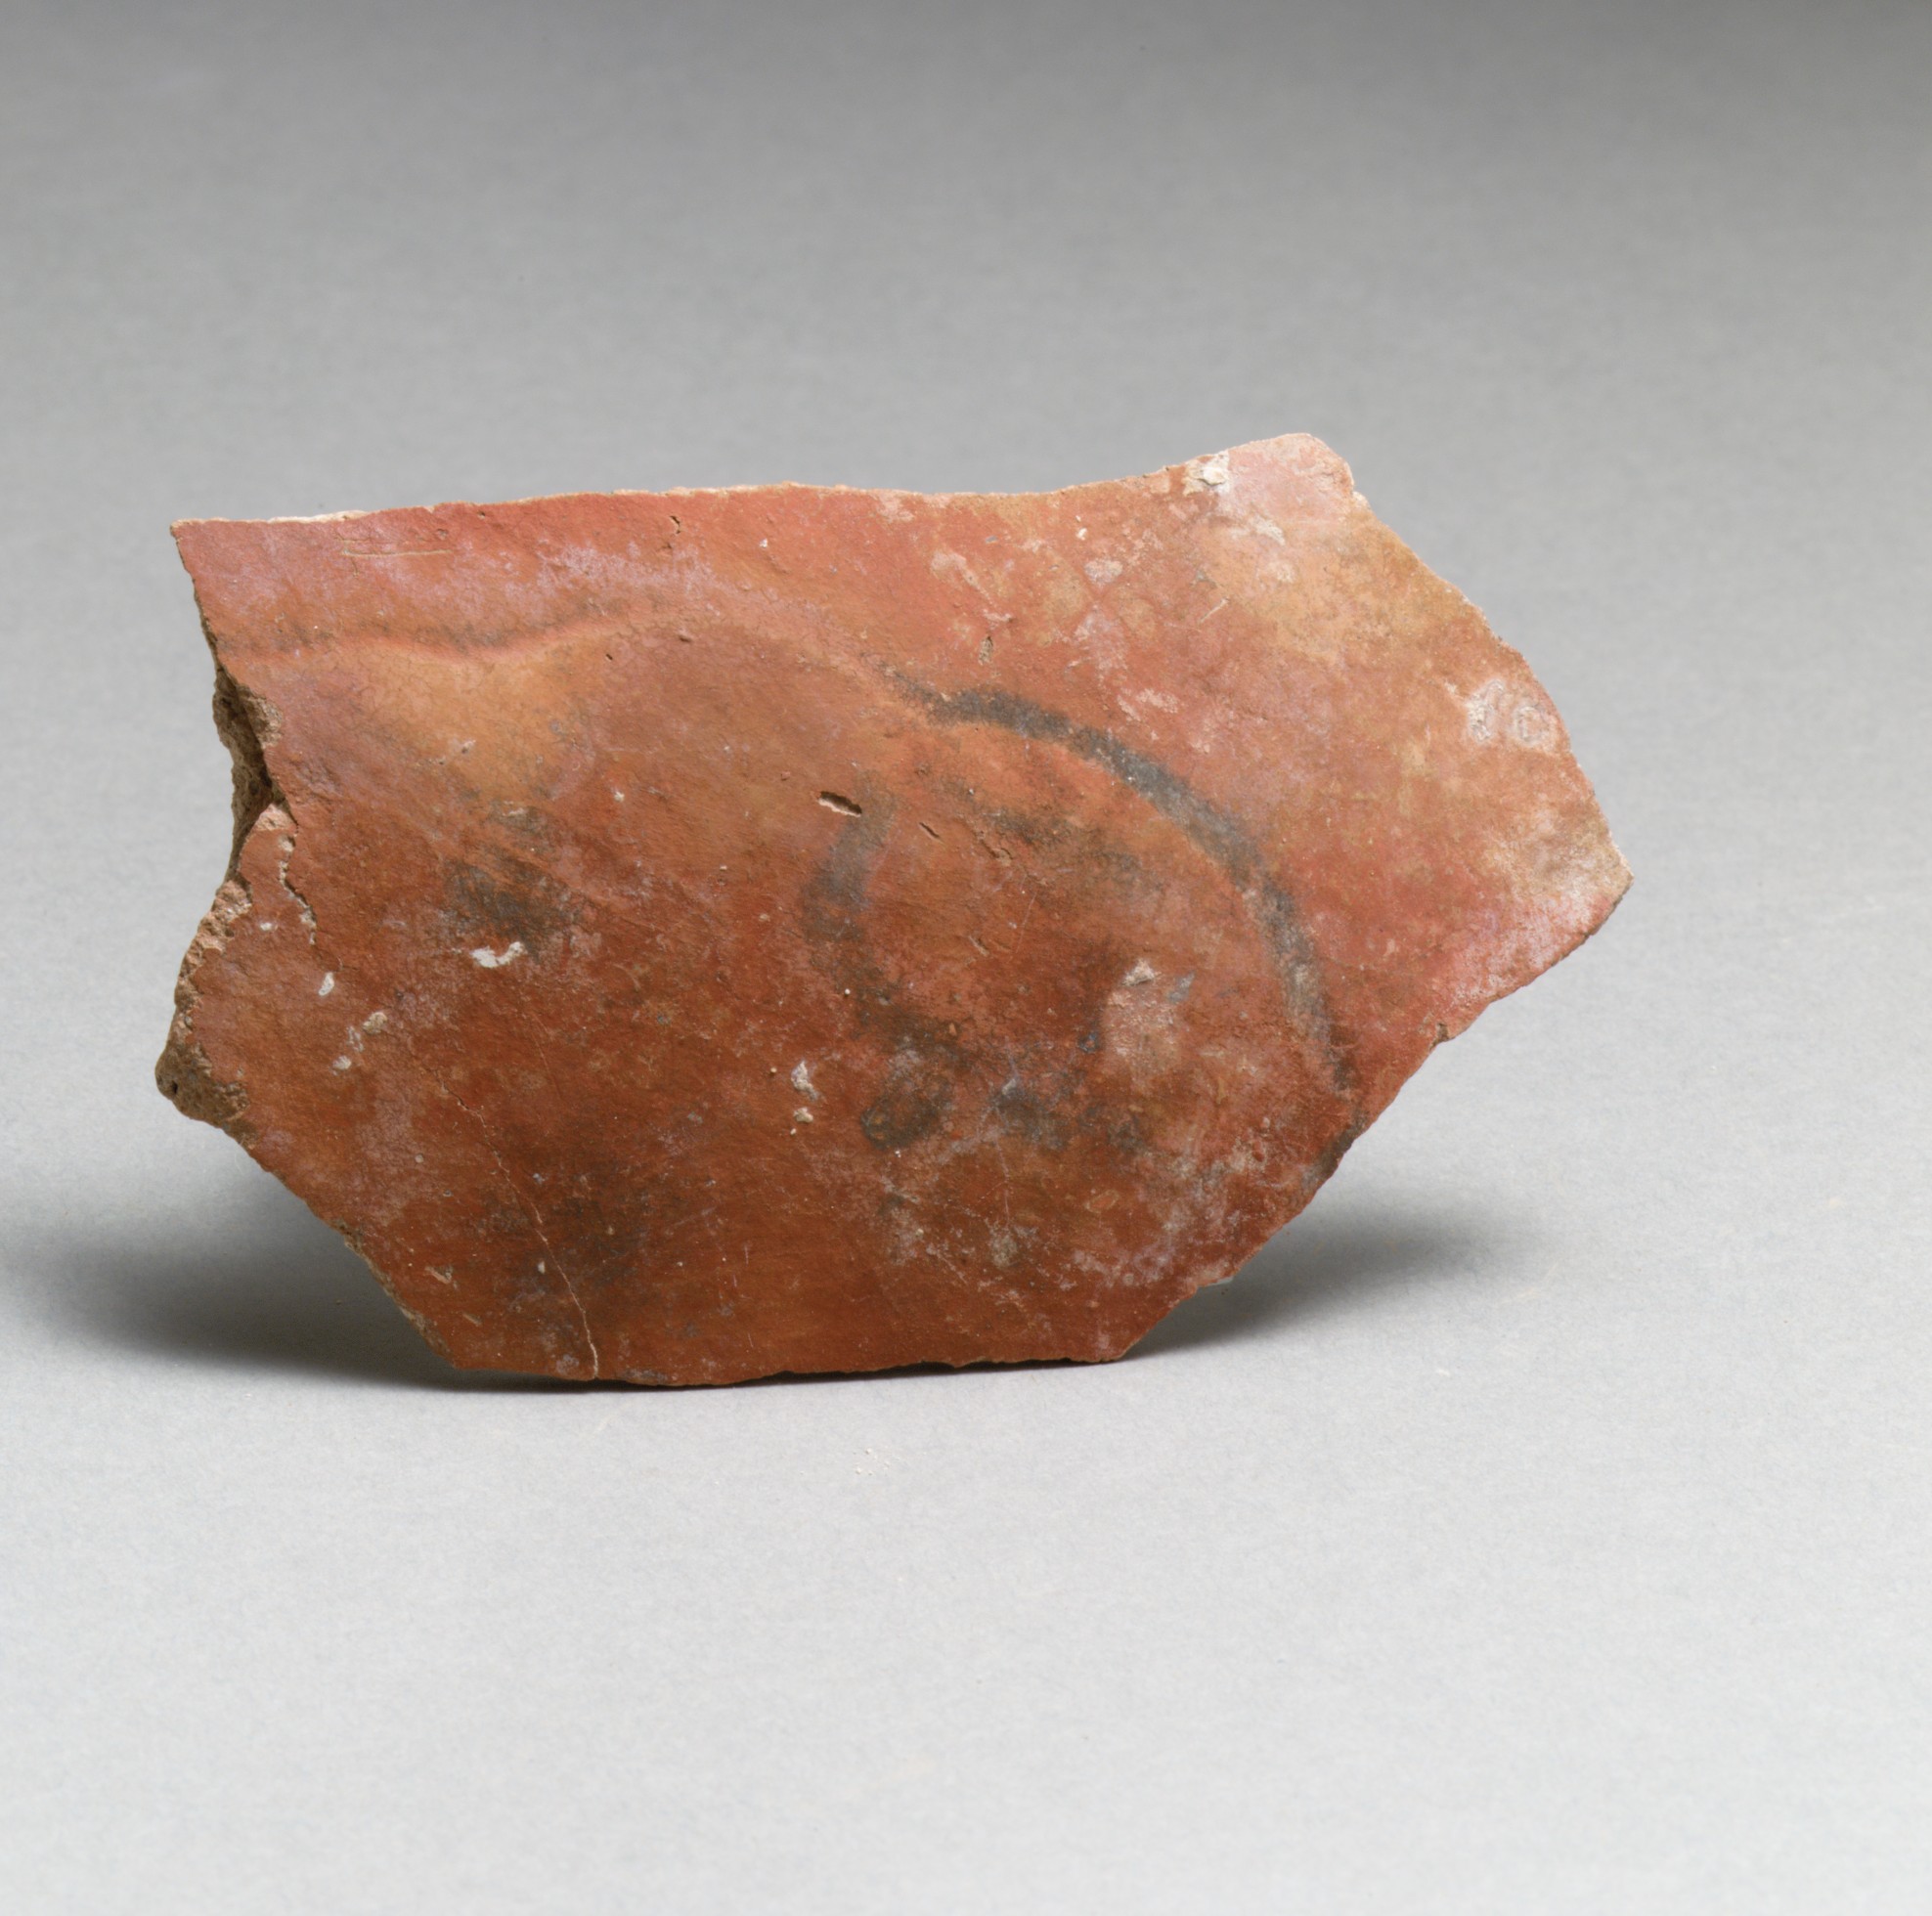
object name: vase fragment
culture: minoan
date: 2600-2000 BCE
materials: terracotta